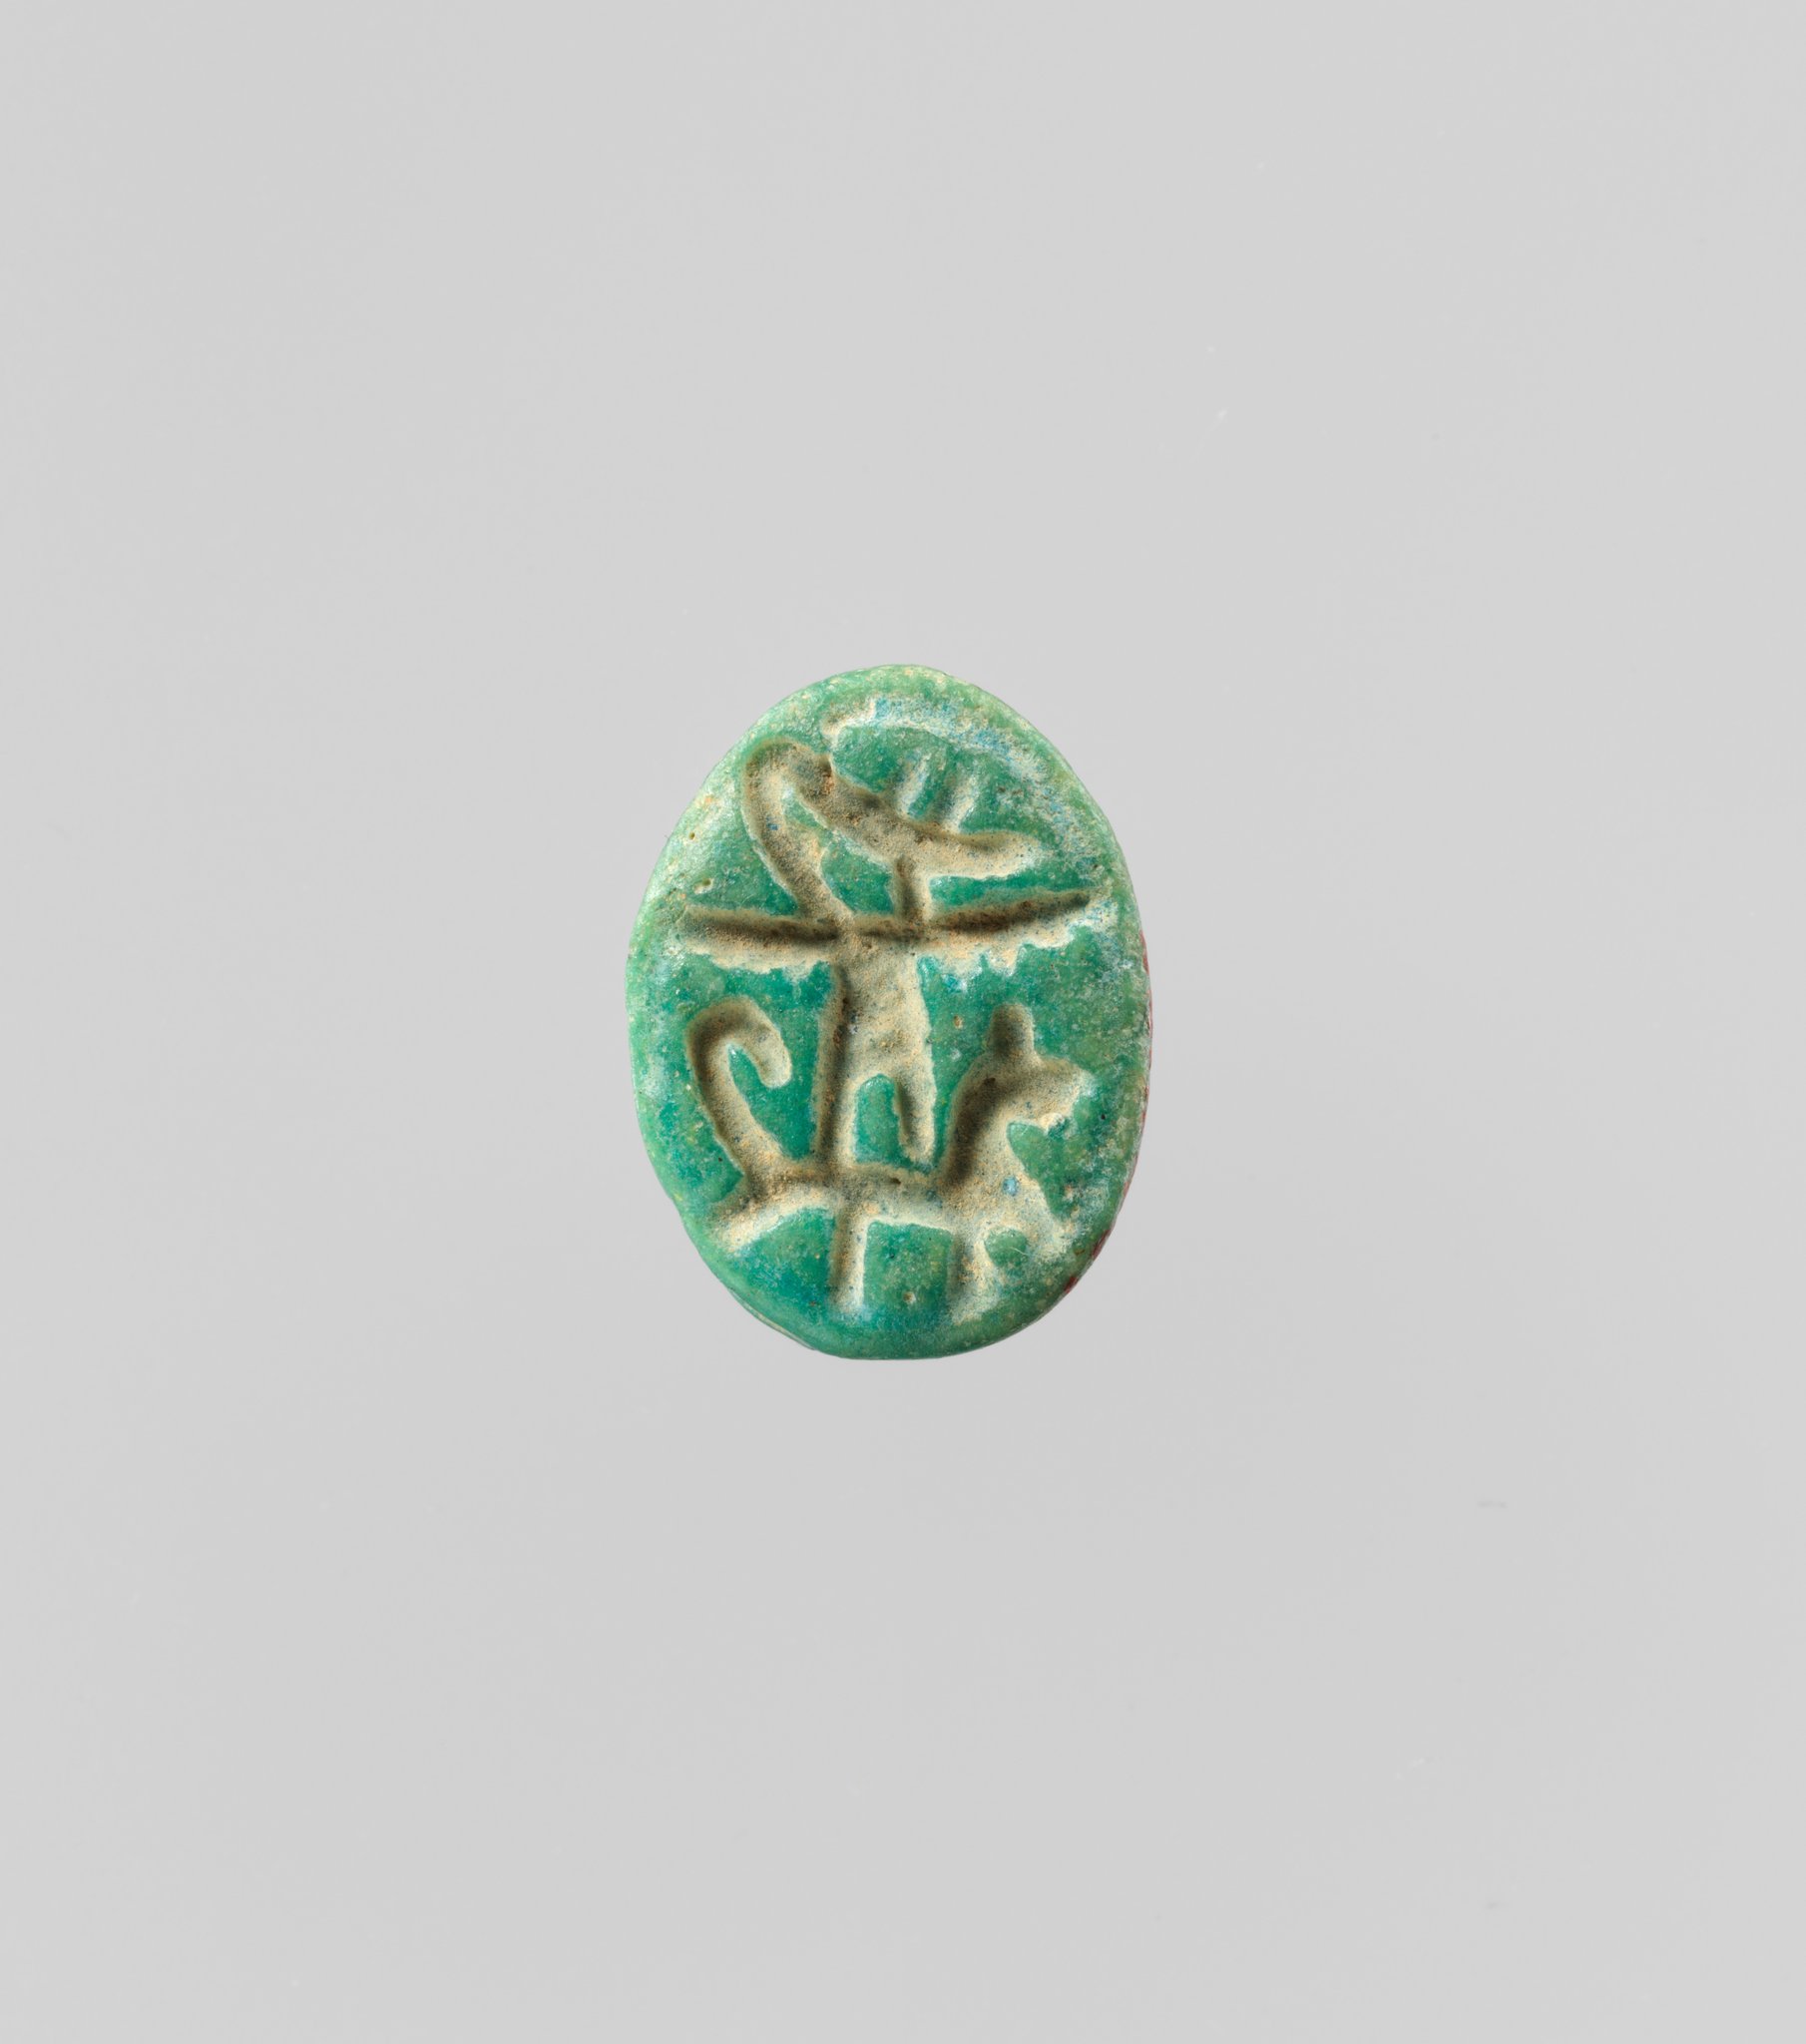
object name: scarab, seth baal, lion, deity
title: Scarab with Figure of Seth-Baal on a Lion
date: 1295-1070 BCE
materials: faience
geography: egypt